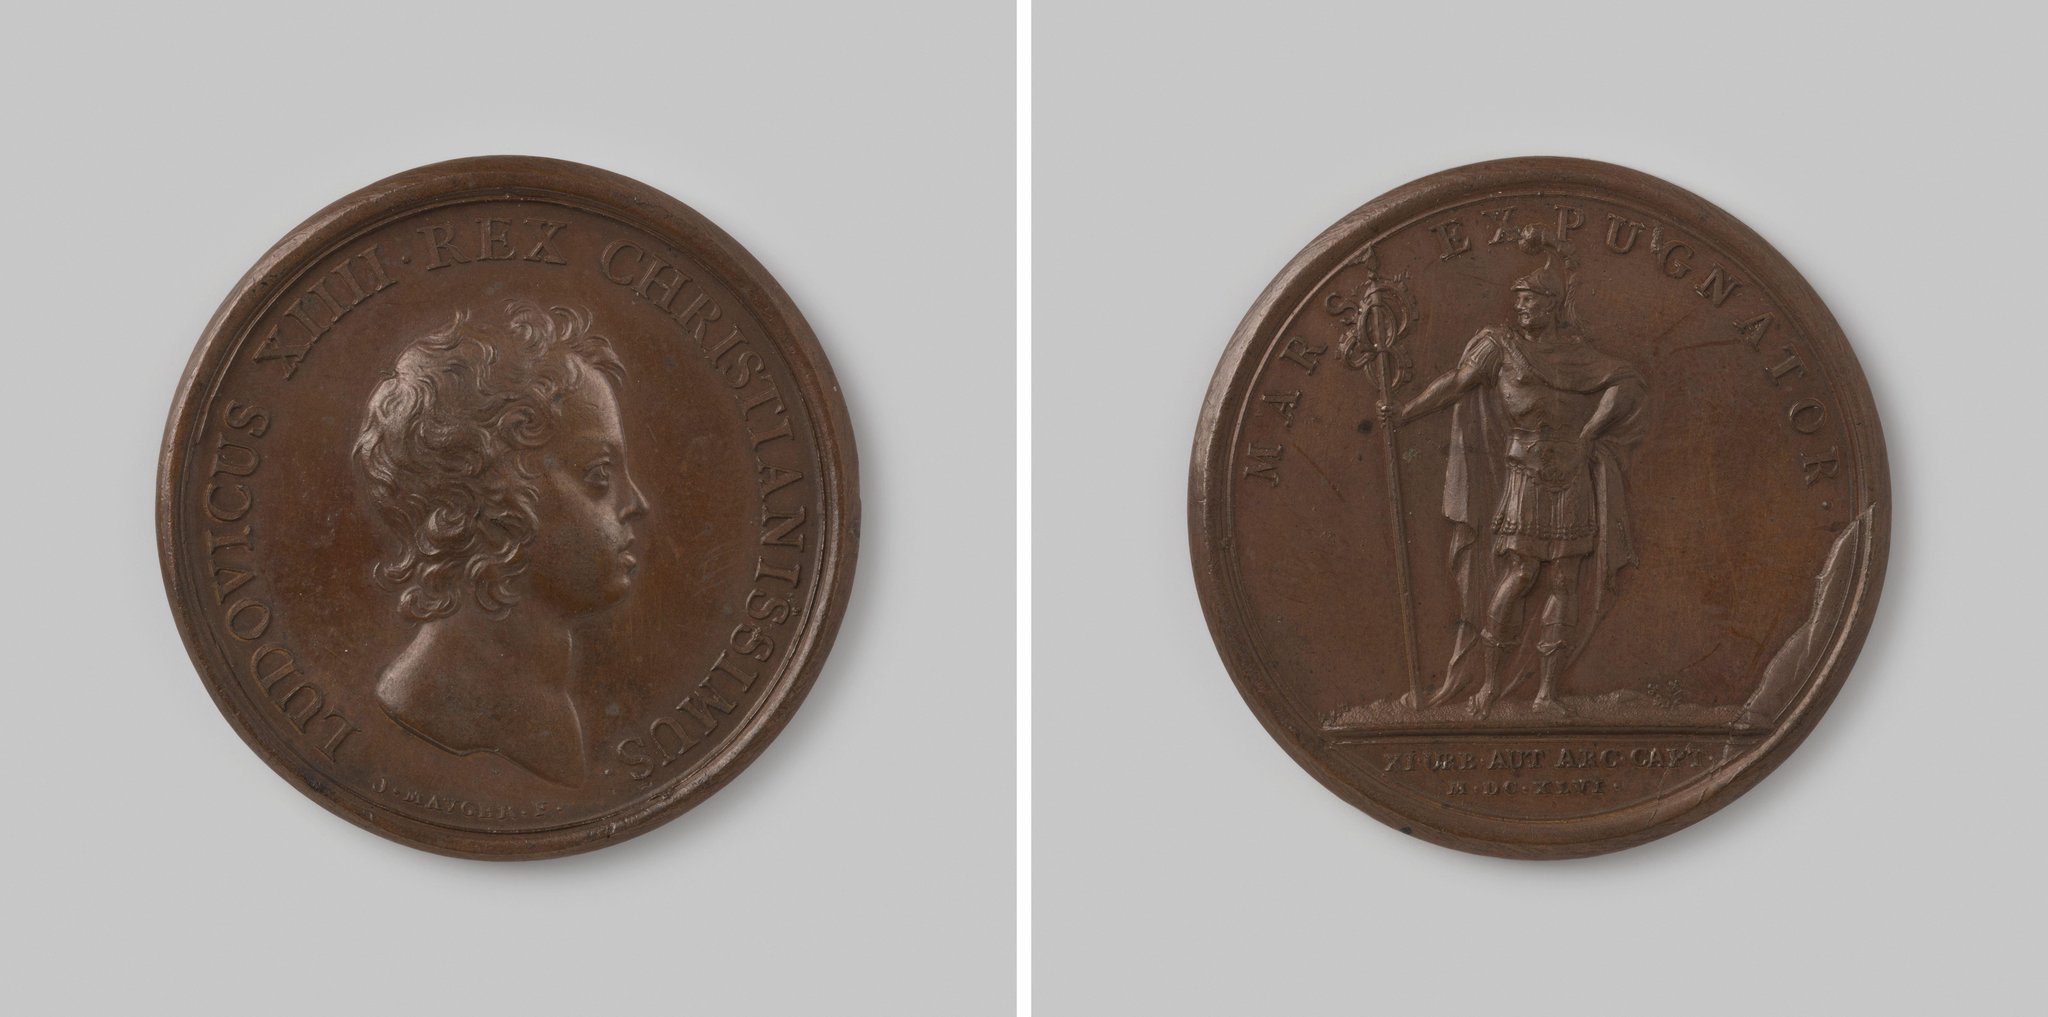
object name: history medal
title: Inname van elf steden en forten door Frankrijk 1646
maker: jean mauger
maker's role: medailleur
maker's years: 1648-1722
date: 1646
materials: copper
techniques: striking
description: Koperen penning, op de voorzijde het jeugdig portret van Koning Lodewijk XIV naar rechts met omschrift, op de keerzijde Mars staand met een lans waaraan stadskronen, met omschrift en afsnedetekst.